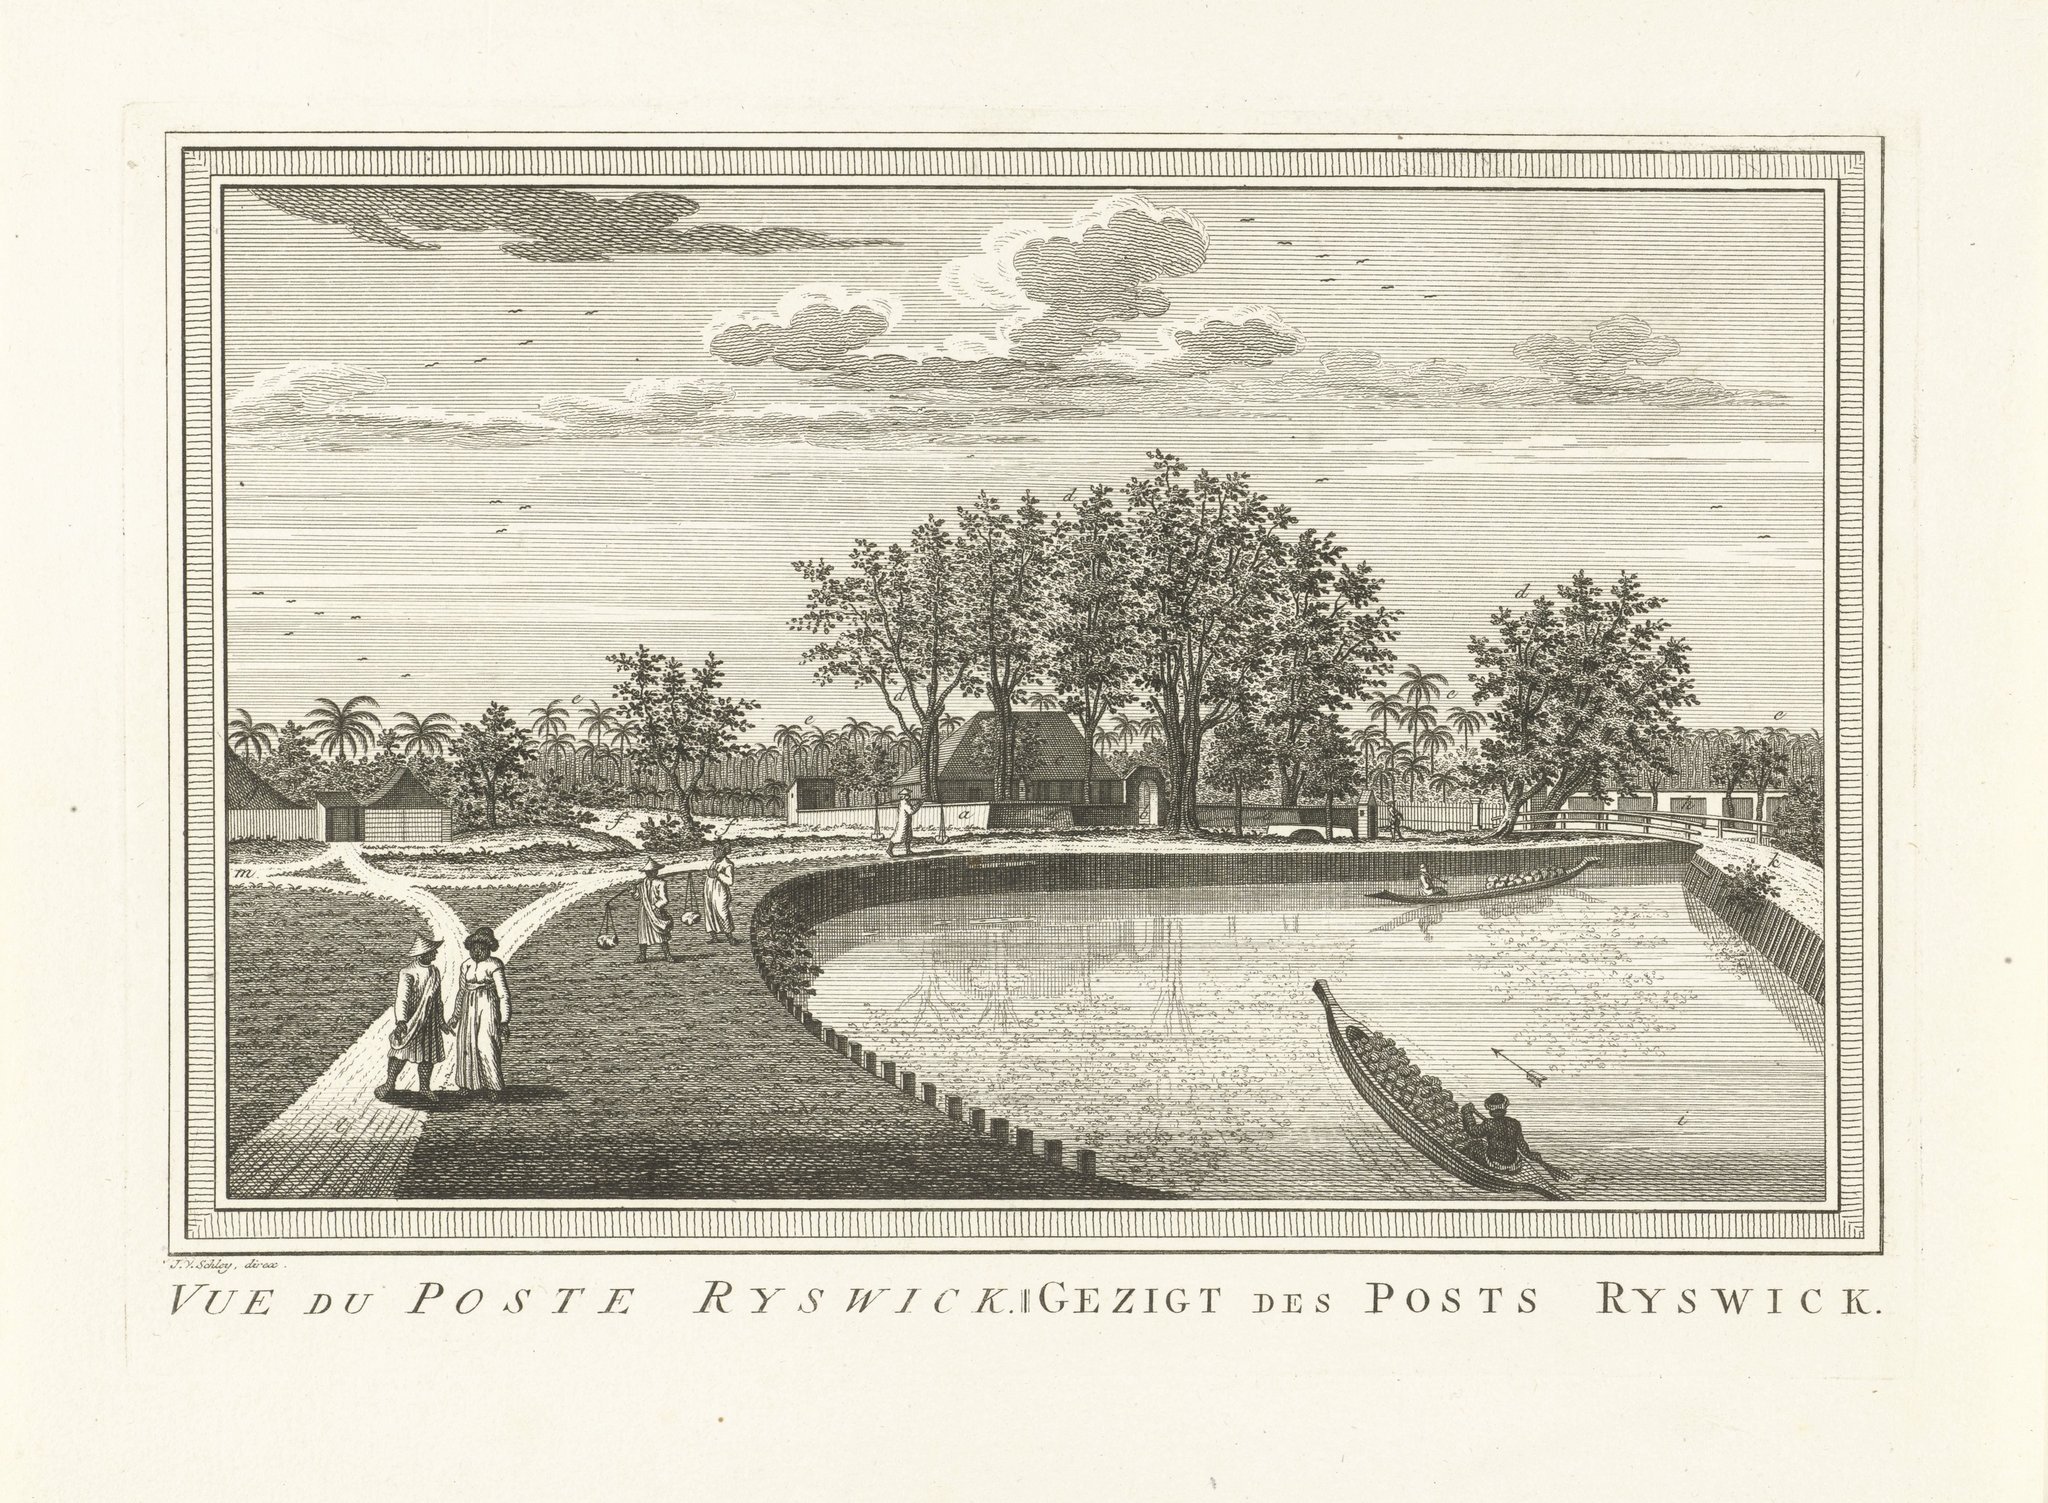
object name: print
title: Gezicht op de post Rijswijk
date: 1747-1779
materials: paper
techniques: engraving, etching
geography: the hague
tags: canoeing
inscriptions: collector's mark: Lugt 2228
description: Prent ook gebruikt in: Bois, J.P.J. du: Histoire Générale Des Voyages, Ou Nouvelle Collection De Toutes Les Relations De Voyages Par Mer Et Par Terre, deel XVII, Den Haag: Pierre de Hondt, 1763, na p. 264. En in: Historische beschryving der reizen, of Nieuwe en volkoome verzameling van de aller-waardigste en zeldsaamste zee- en landtogten, deel XIX, Den Haag: Pierre de Hondt, 1770, na p. 406.